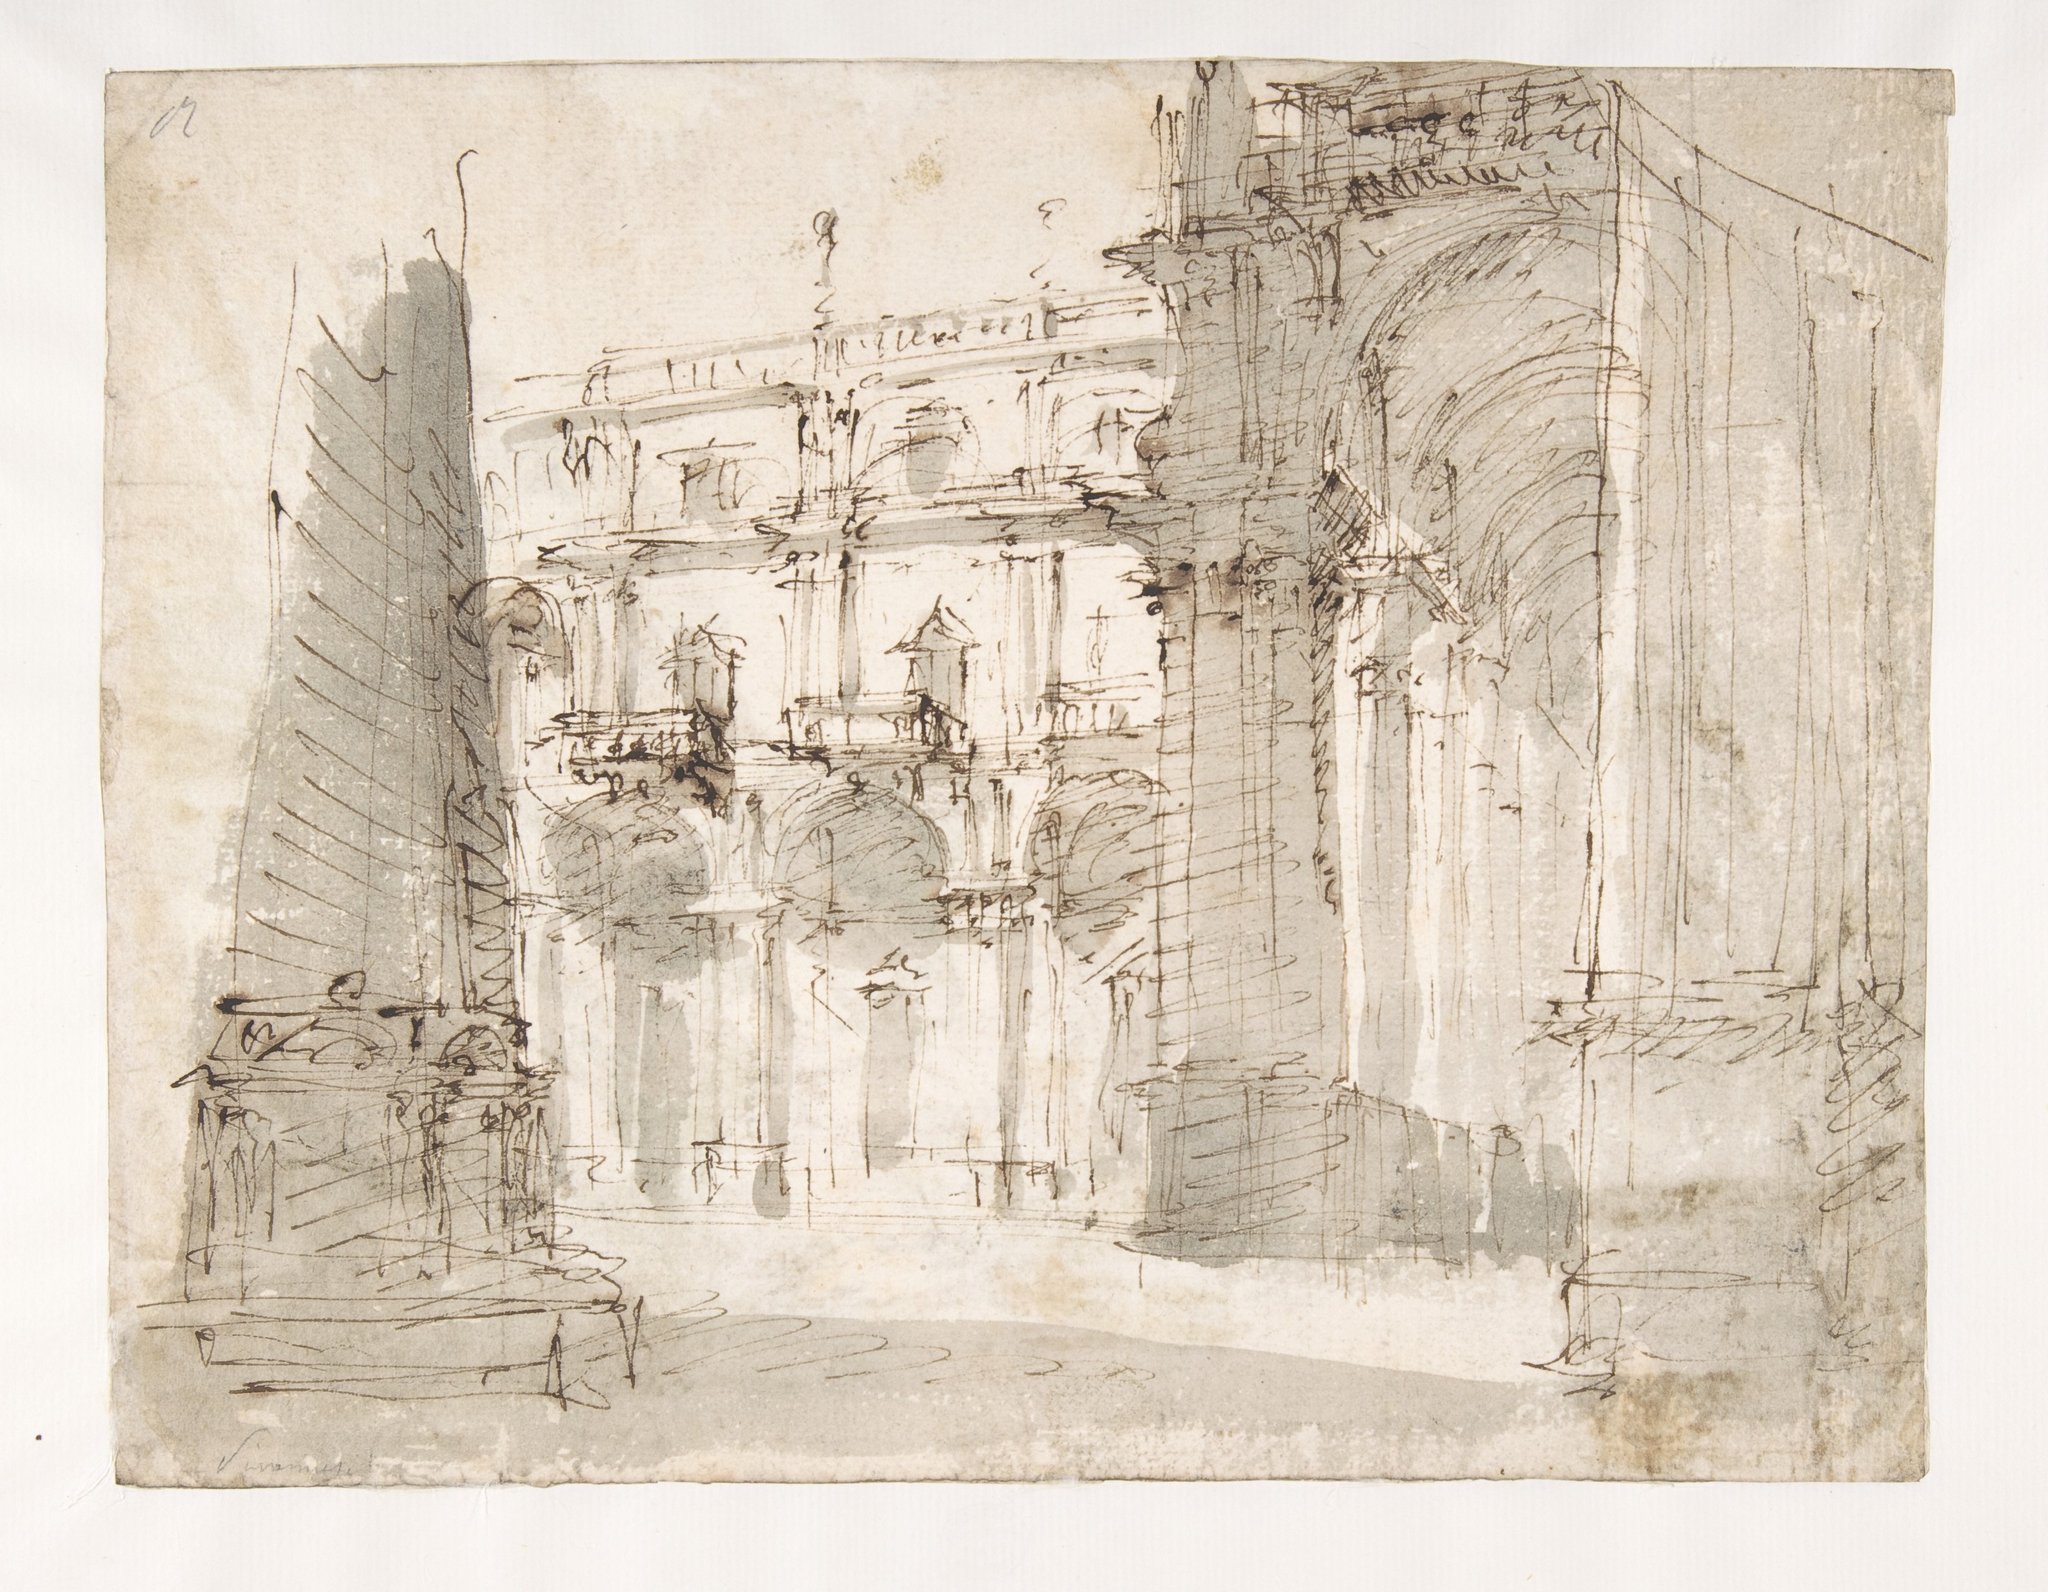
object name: drawing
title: Street Scene with a Palace Façade and an Arcade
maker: fabrizio galliari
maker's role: artist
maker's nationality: italian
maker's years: 1709-1790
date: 1707-1794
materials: chalk, ink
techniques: brush, pen, wash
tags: buildings